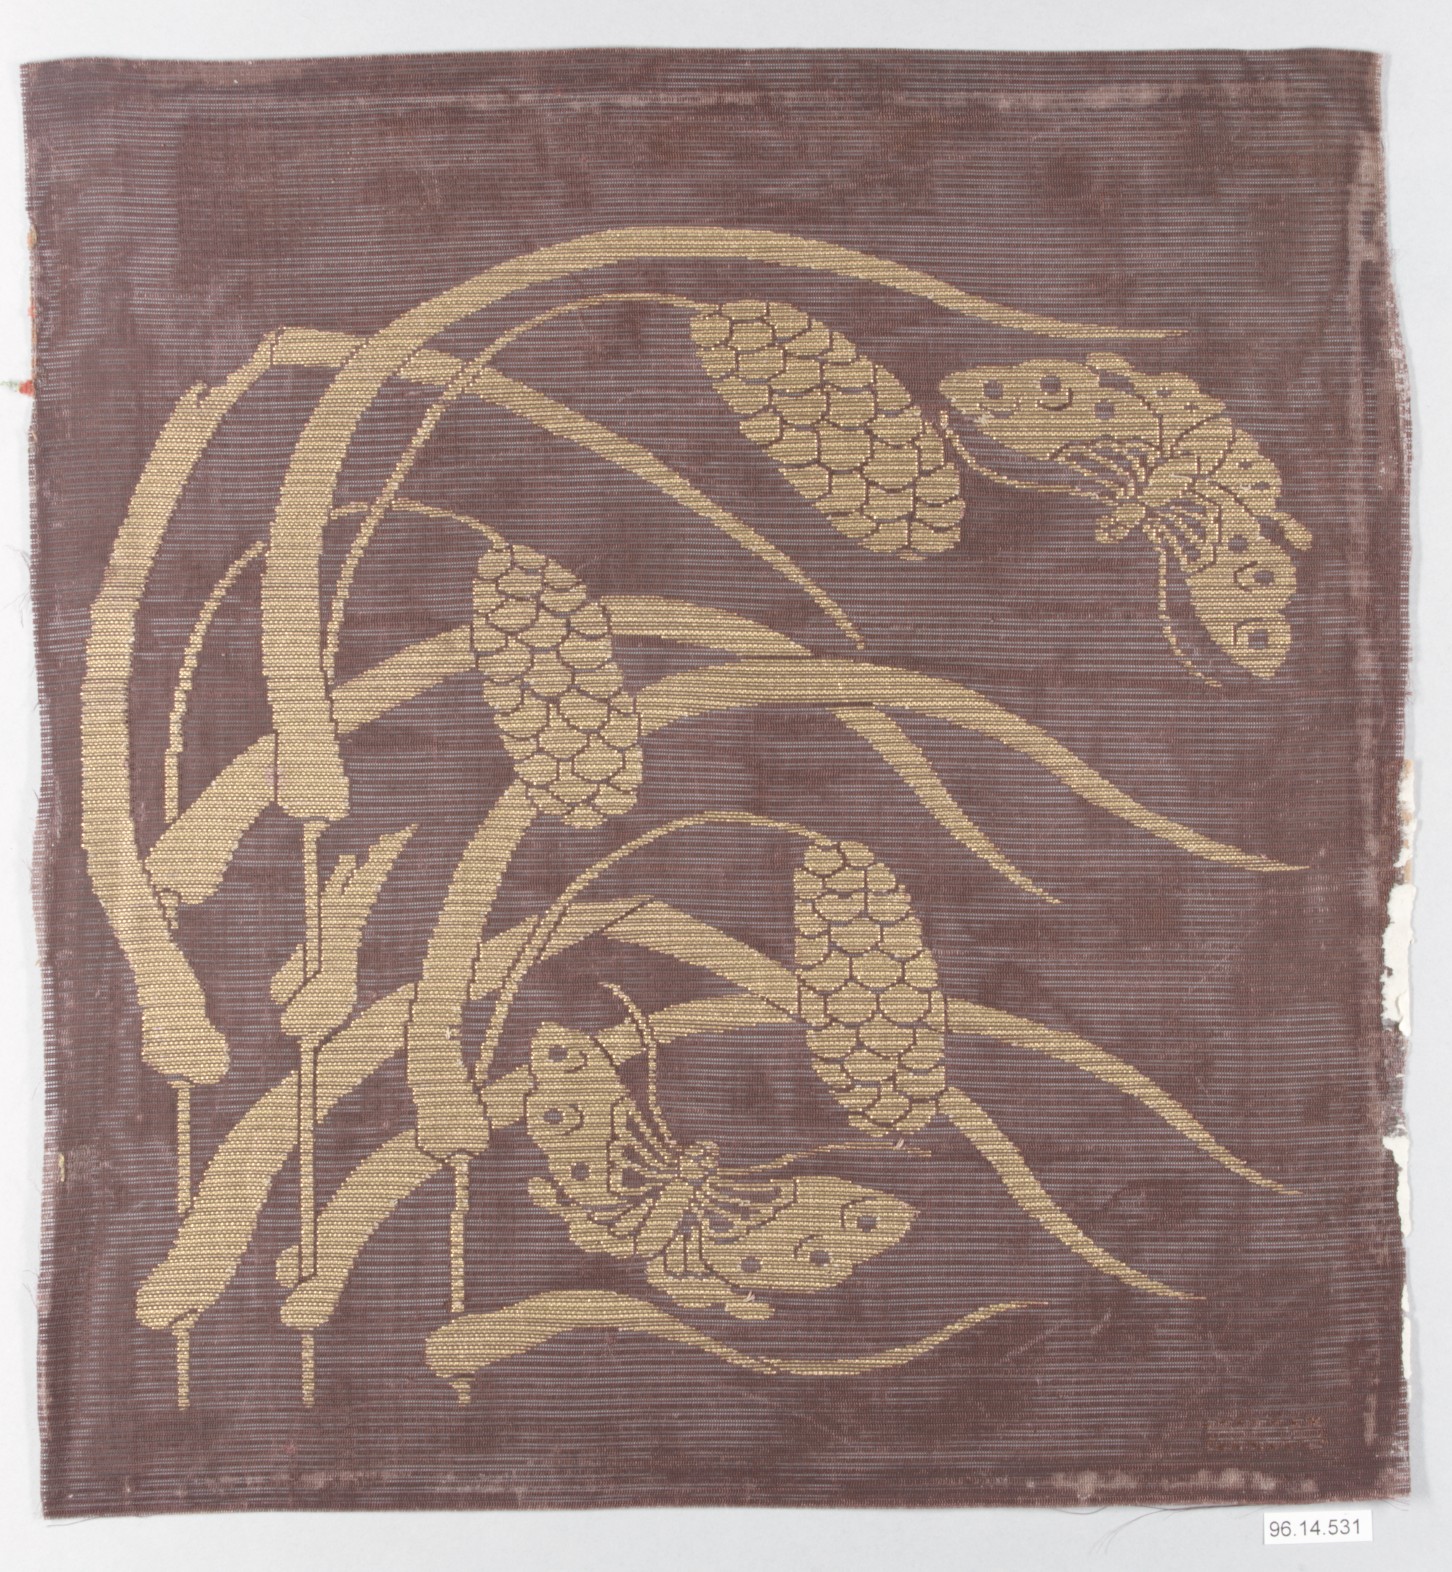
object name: piece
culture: japanese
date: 1801-1833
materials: silk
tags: butterflies,plants